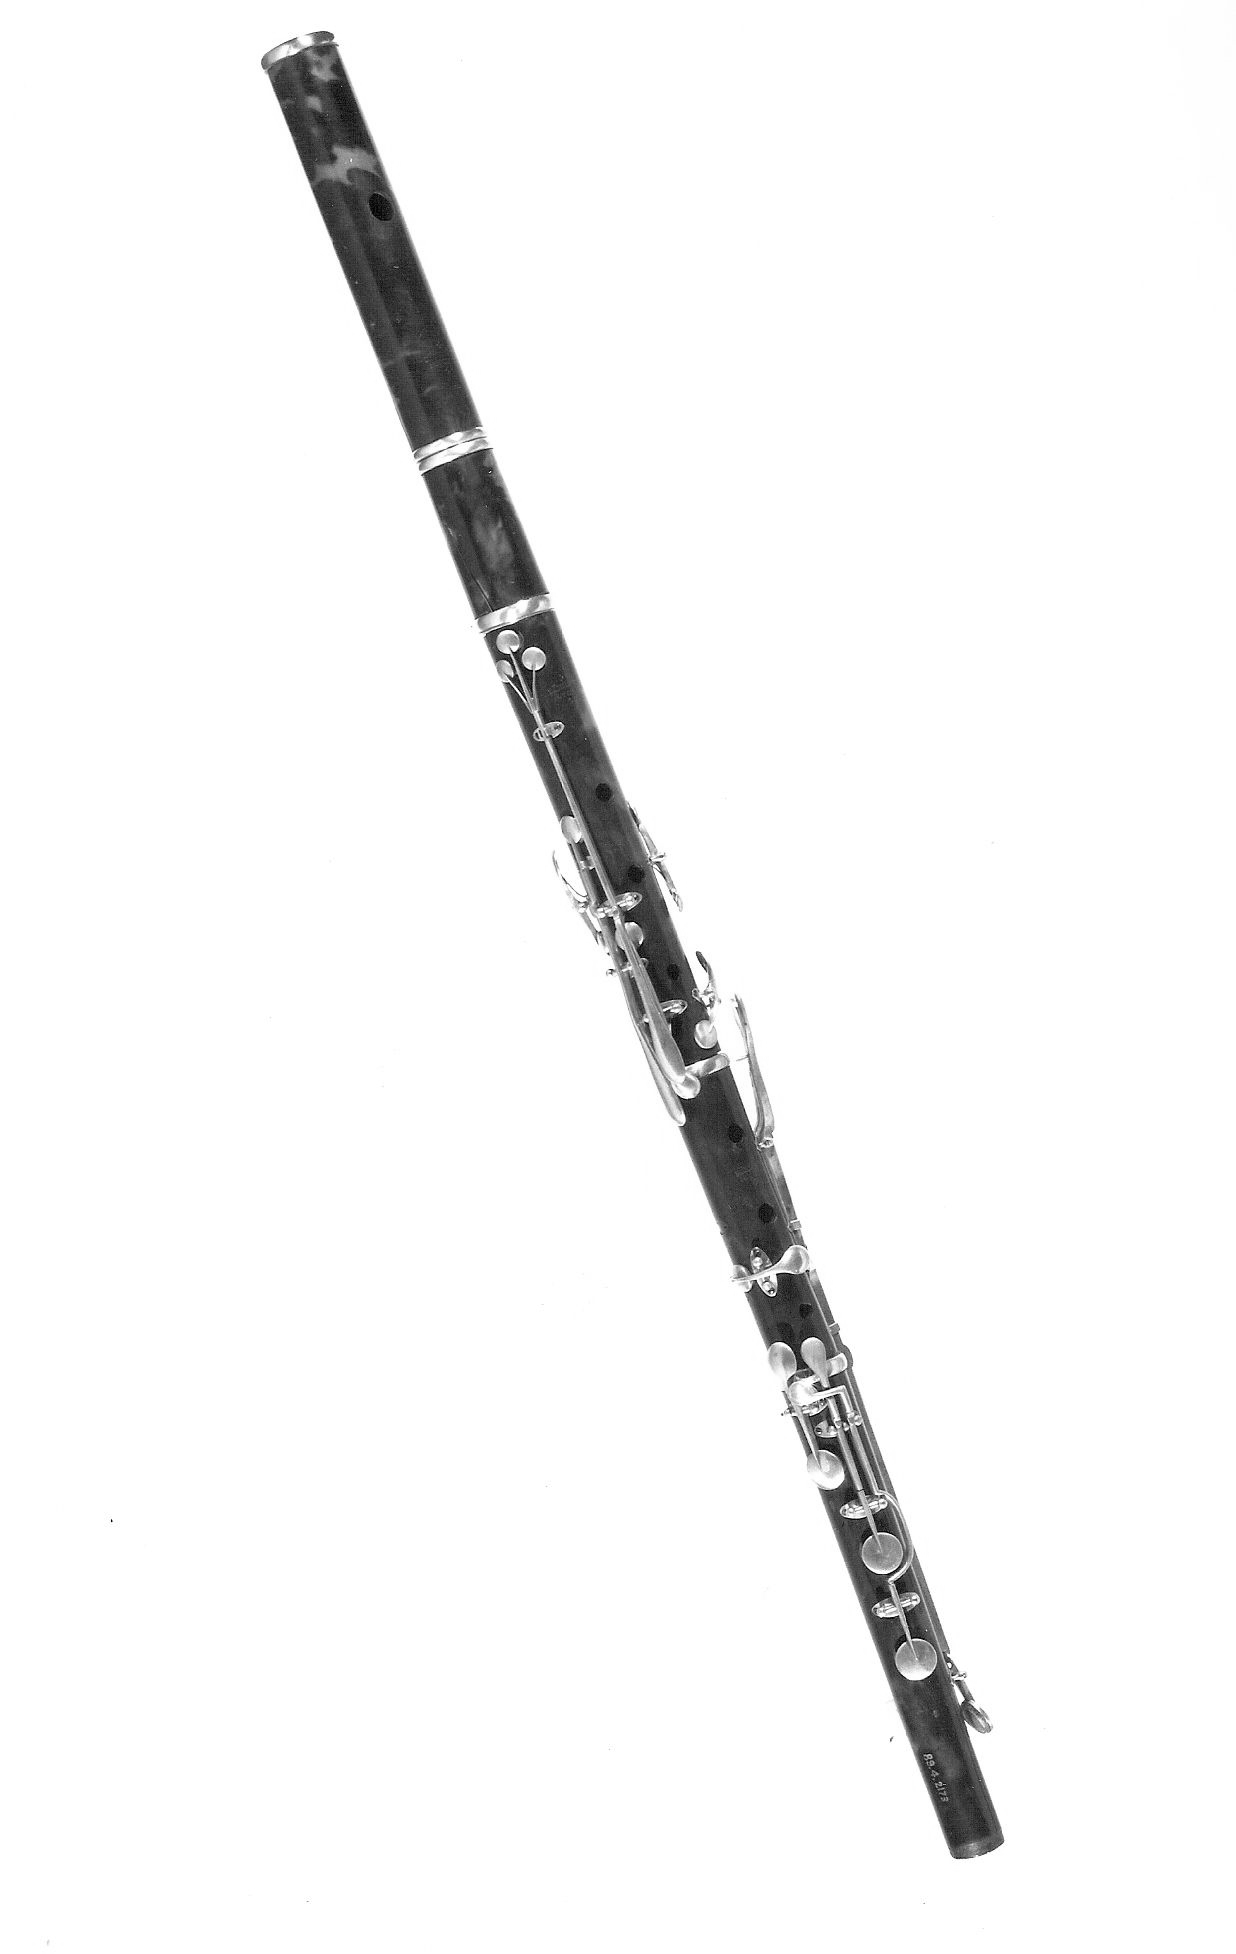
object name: transverse flute in b flat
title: Transverse Flute in B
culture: american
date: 1856-1890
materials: silver, shell, wood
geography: united states